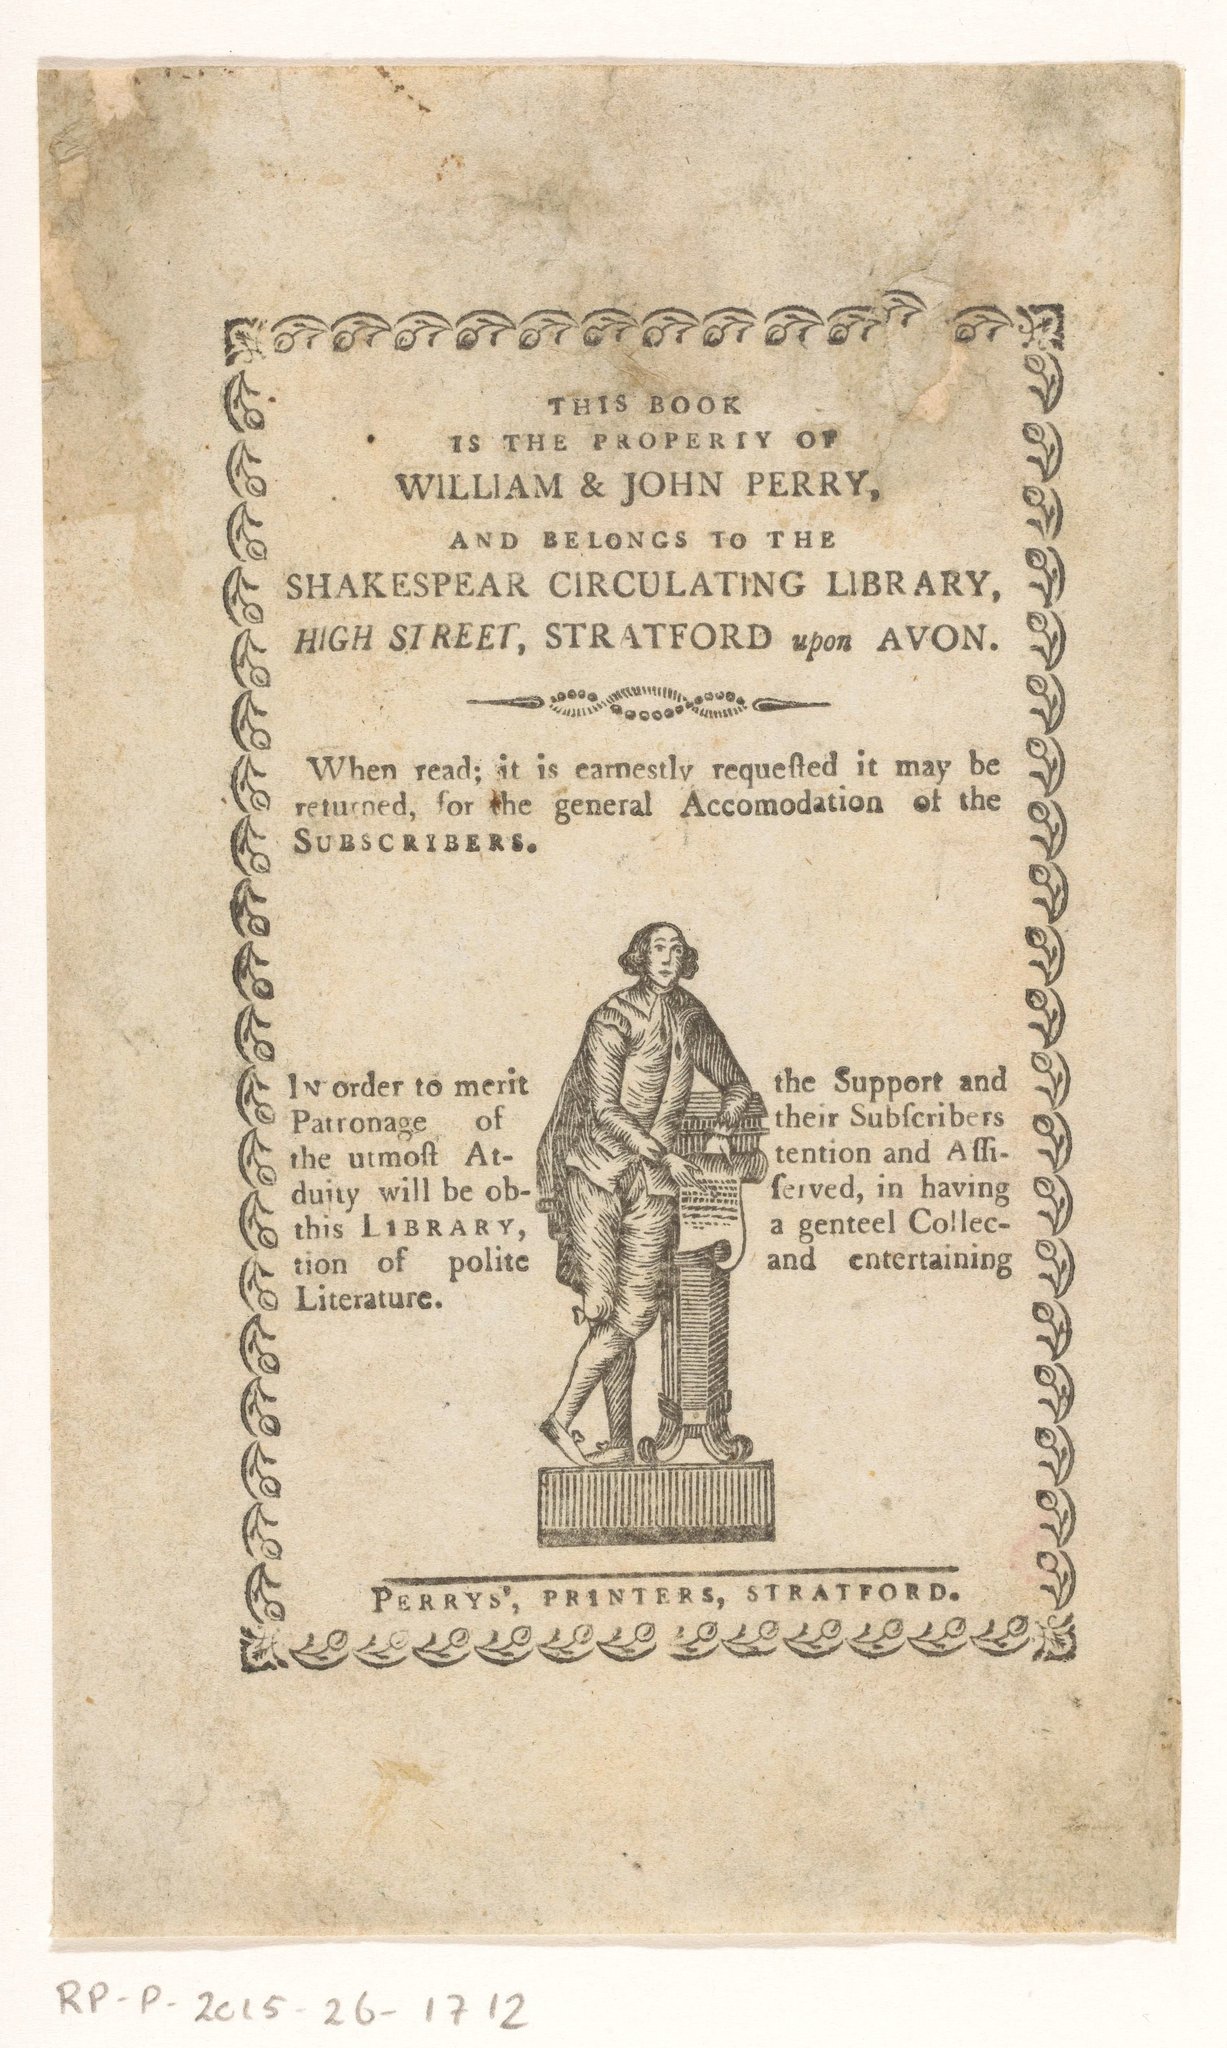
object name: bookplate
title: Ex libris van de Shakespeare Circulating Library te Stratford-upon-Avon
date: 1803-1807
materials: paper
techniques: letterpress printing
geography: stratford-upon-avon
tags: william shakespeare, writer, poet, author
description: Beeld van William Shakespeare met een vel papier in zijn hand, leunend op een pilaar.